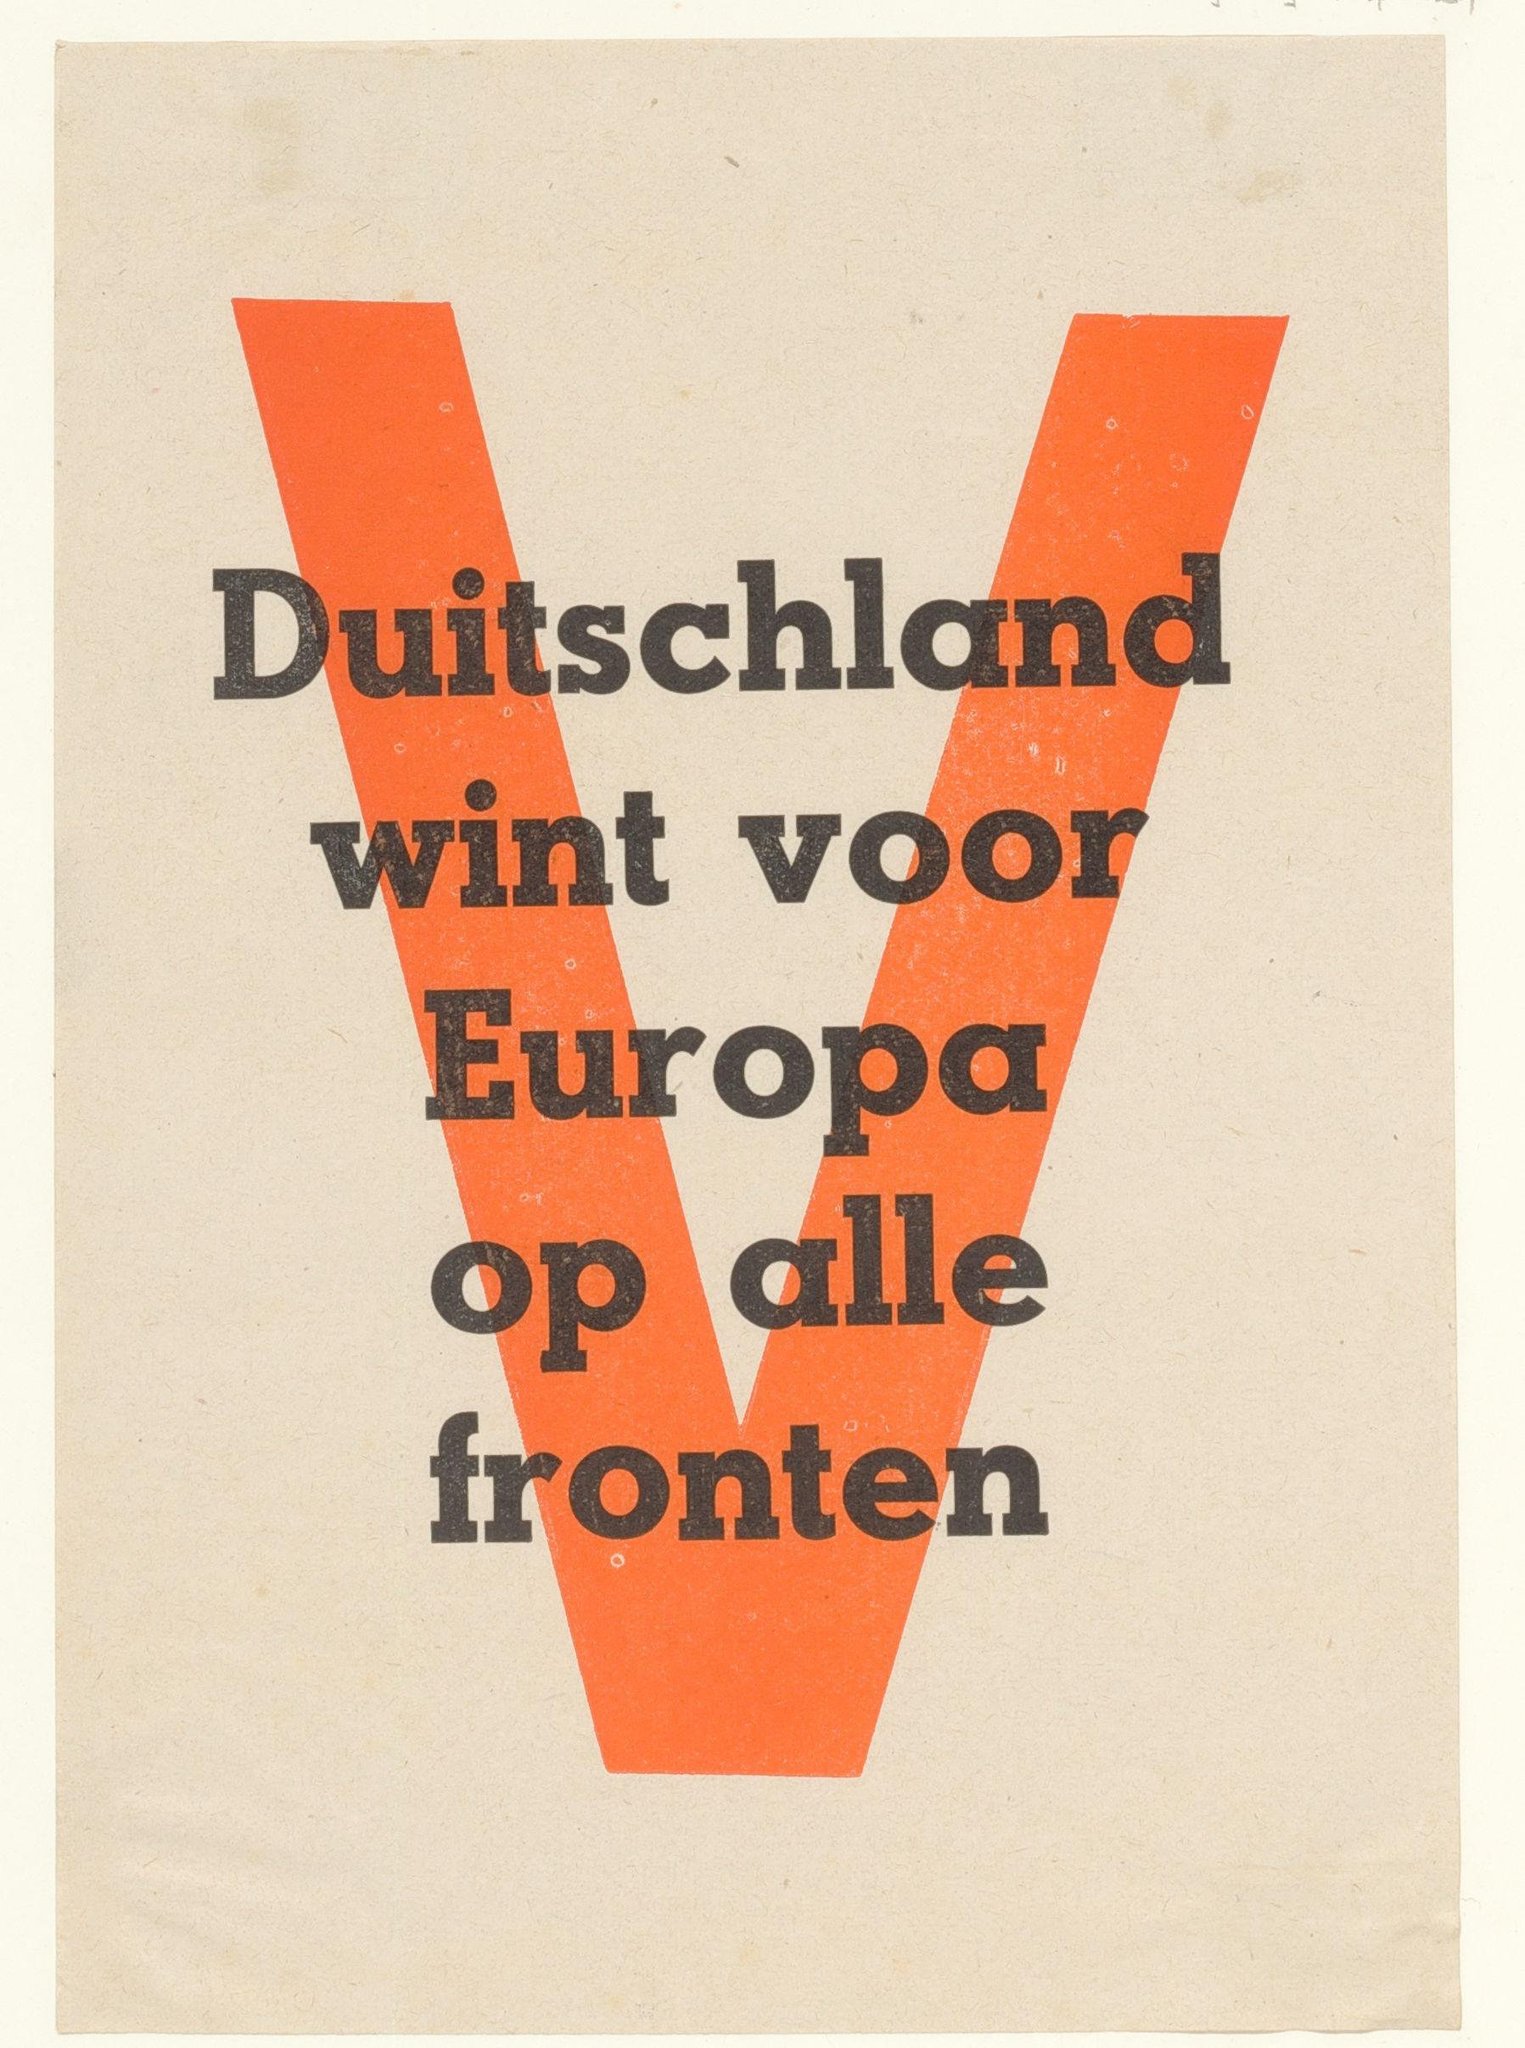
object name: pamphlet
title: V Duitschland wint op alle fronten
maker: Anonymous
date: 1941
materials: paper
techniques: printing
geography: netherlands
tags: political propaganda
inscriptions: collector's mark, collector's mark: Lugt 1641